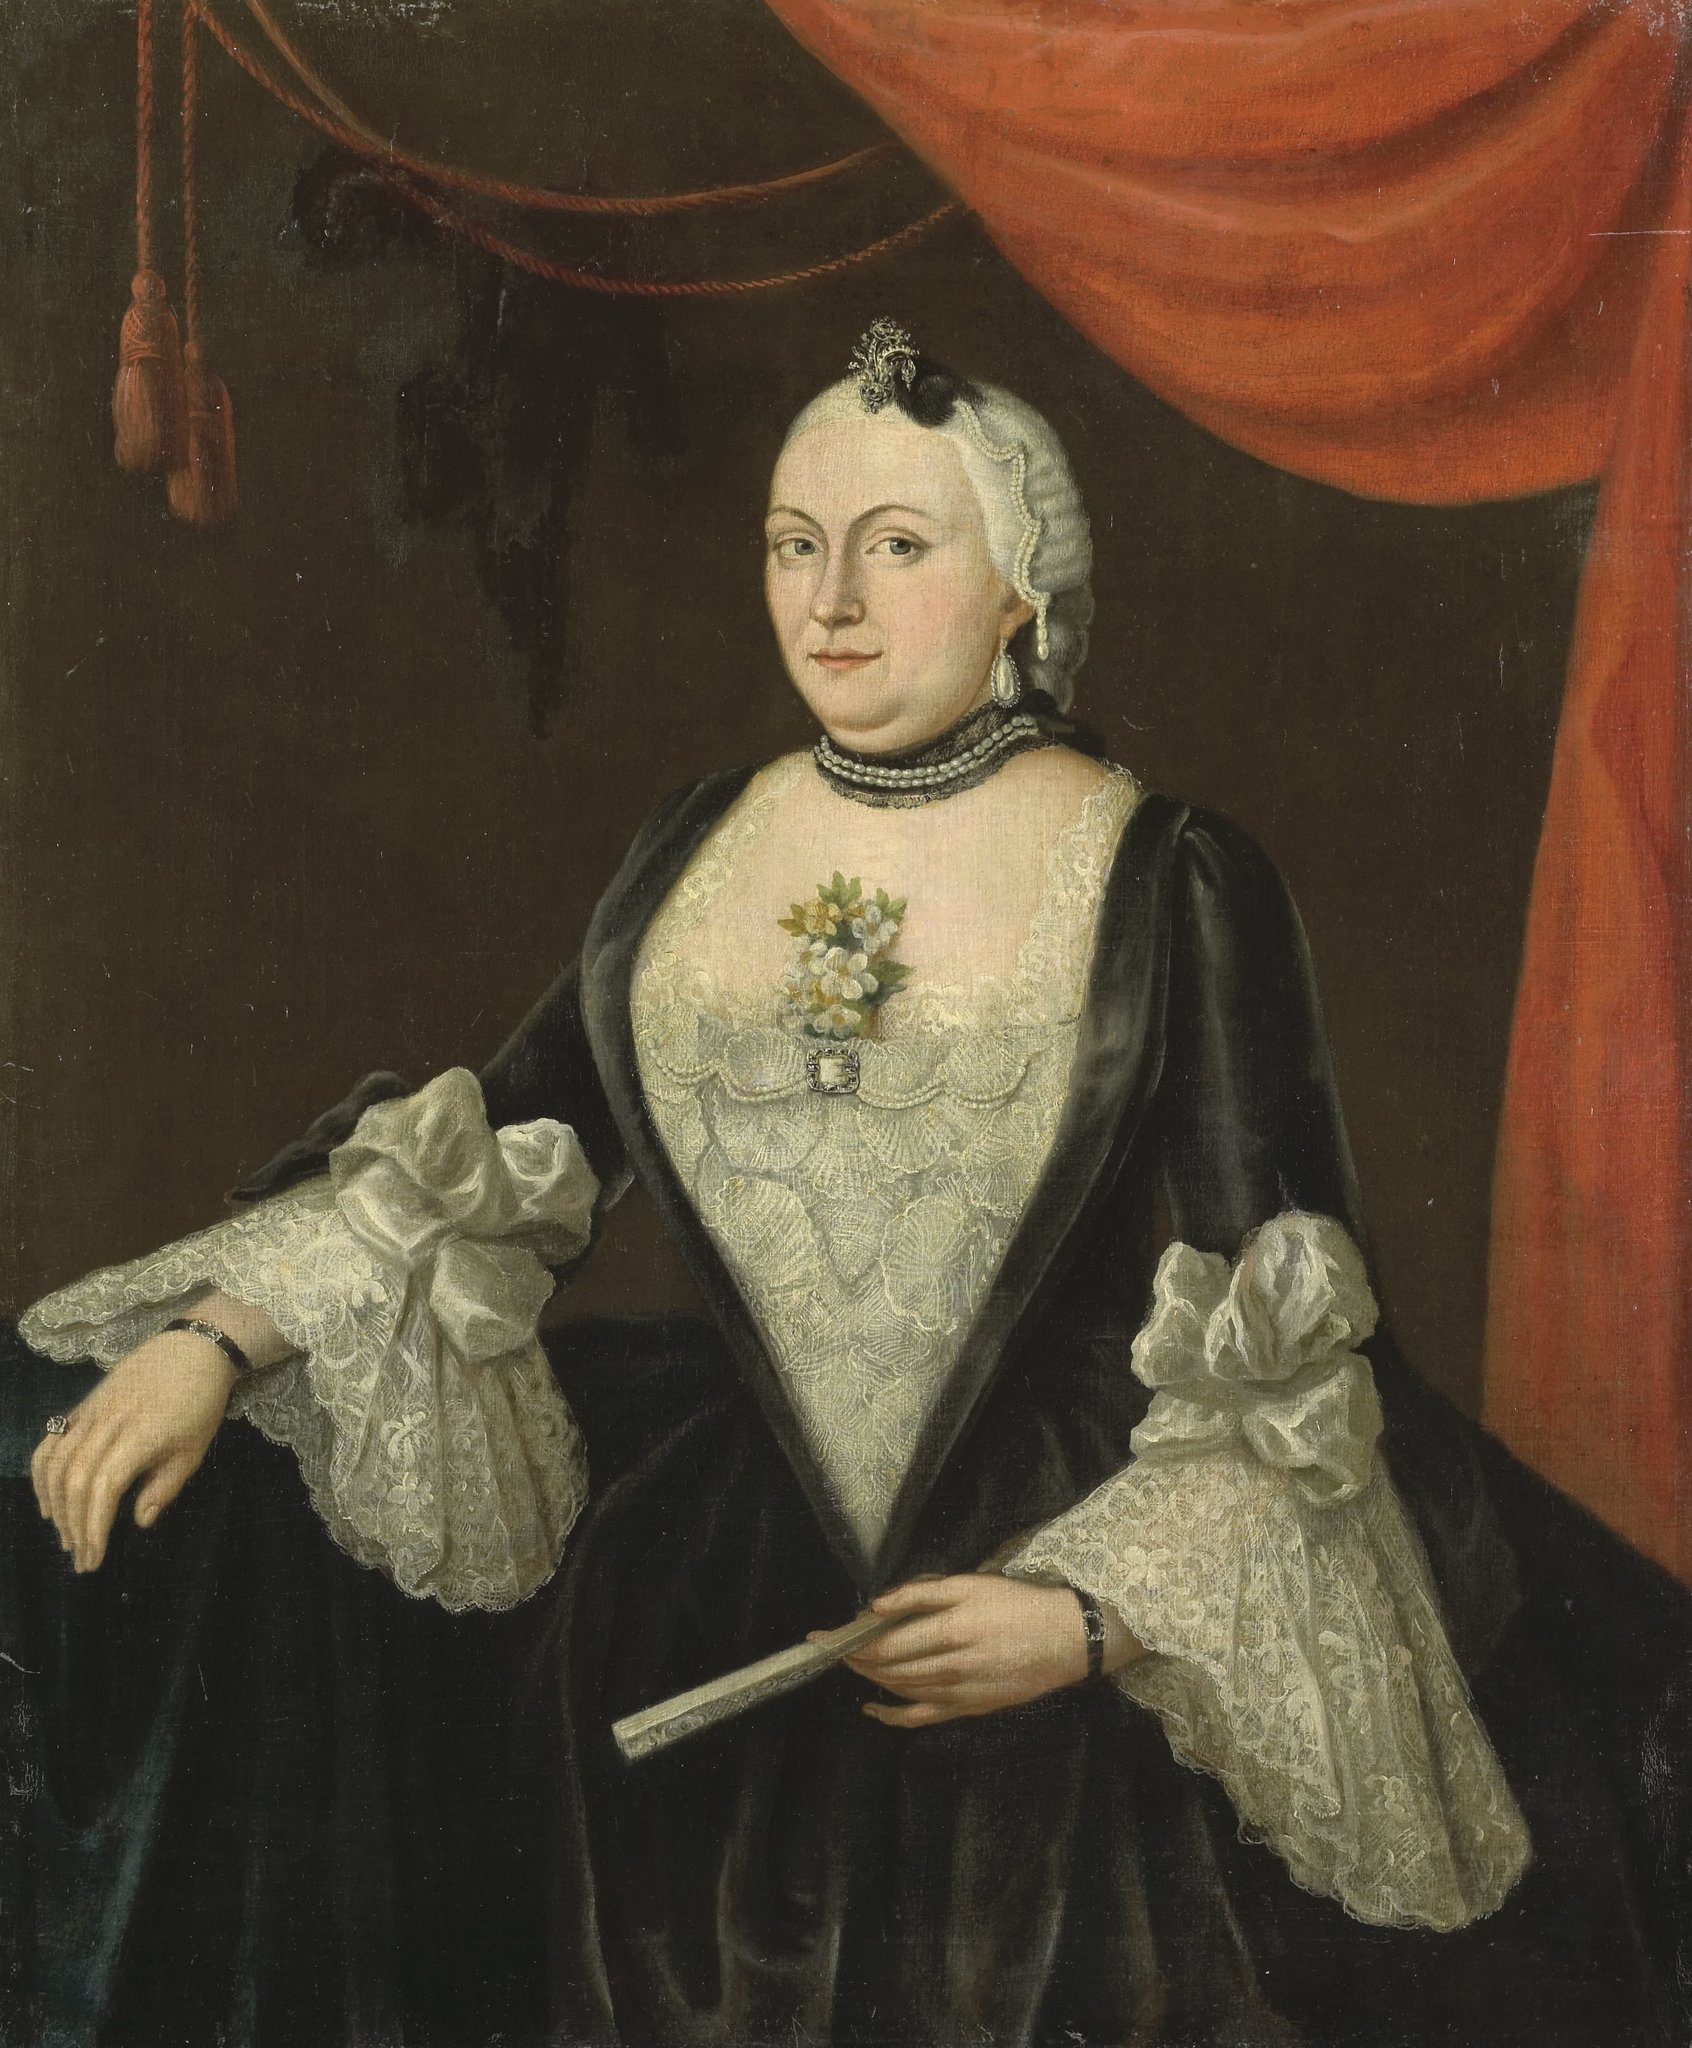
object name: painting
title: Johanna van Rijswijk (b. 1715), Wife of Jan Hendrik van Rijswijk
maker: isaac lodewijk la fargue van nieuwland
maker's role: draughtsman, painter, print maker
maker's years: 1726-1805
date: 1754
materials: canvas, oil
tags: historical persons - bb - woman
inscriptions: inscription: ‘Johanna van Rijswijk Nat 30 November 1715’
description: Portret van Johanna van Rijswijk, echtgenote van Jan Hendrik van Rijswijk. Staand, ten halven lijve, een waaier in de linkerhand. Pendant van SK-A-637.